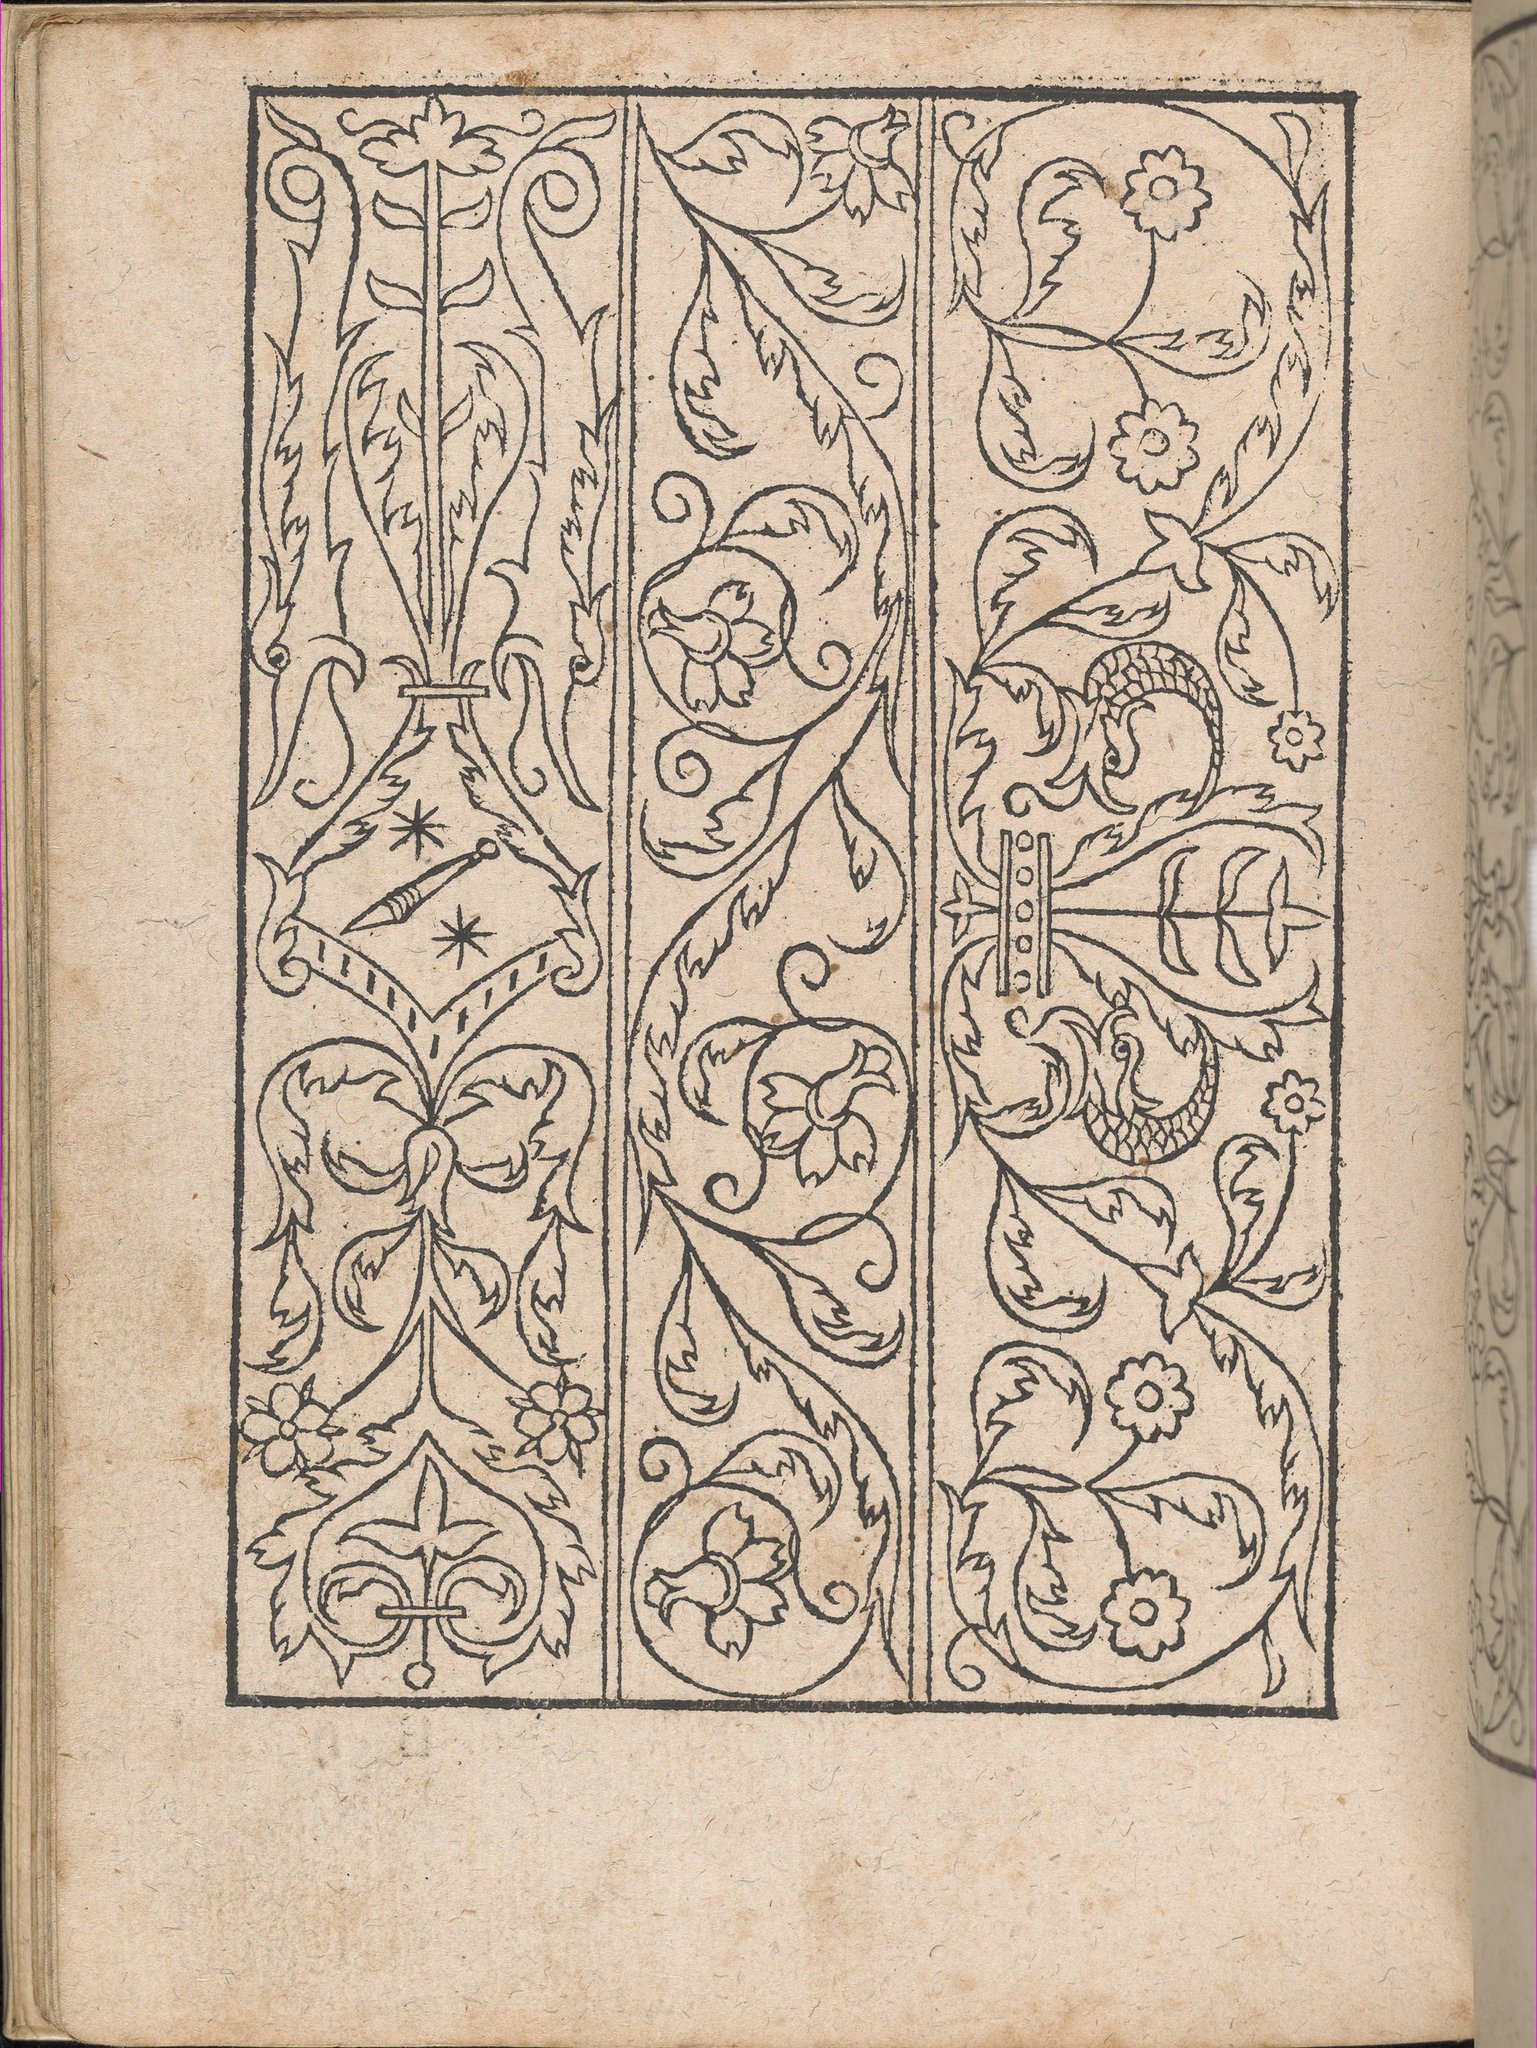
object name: book print ornament architecture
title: New Modelbüch allen Nägerin u. Sydenstickern (Page 18v)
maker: hans hoffman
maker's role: designer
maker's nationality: german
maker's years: 1556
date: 1556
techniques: woodcut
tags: flowers